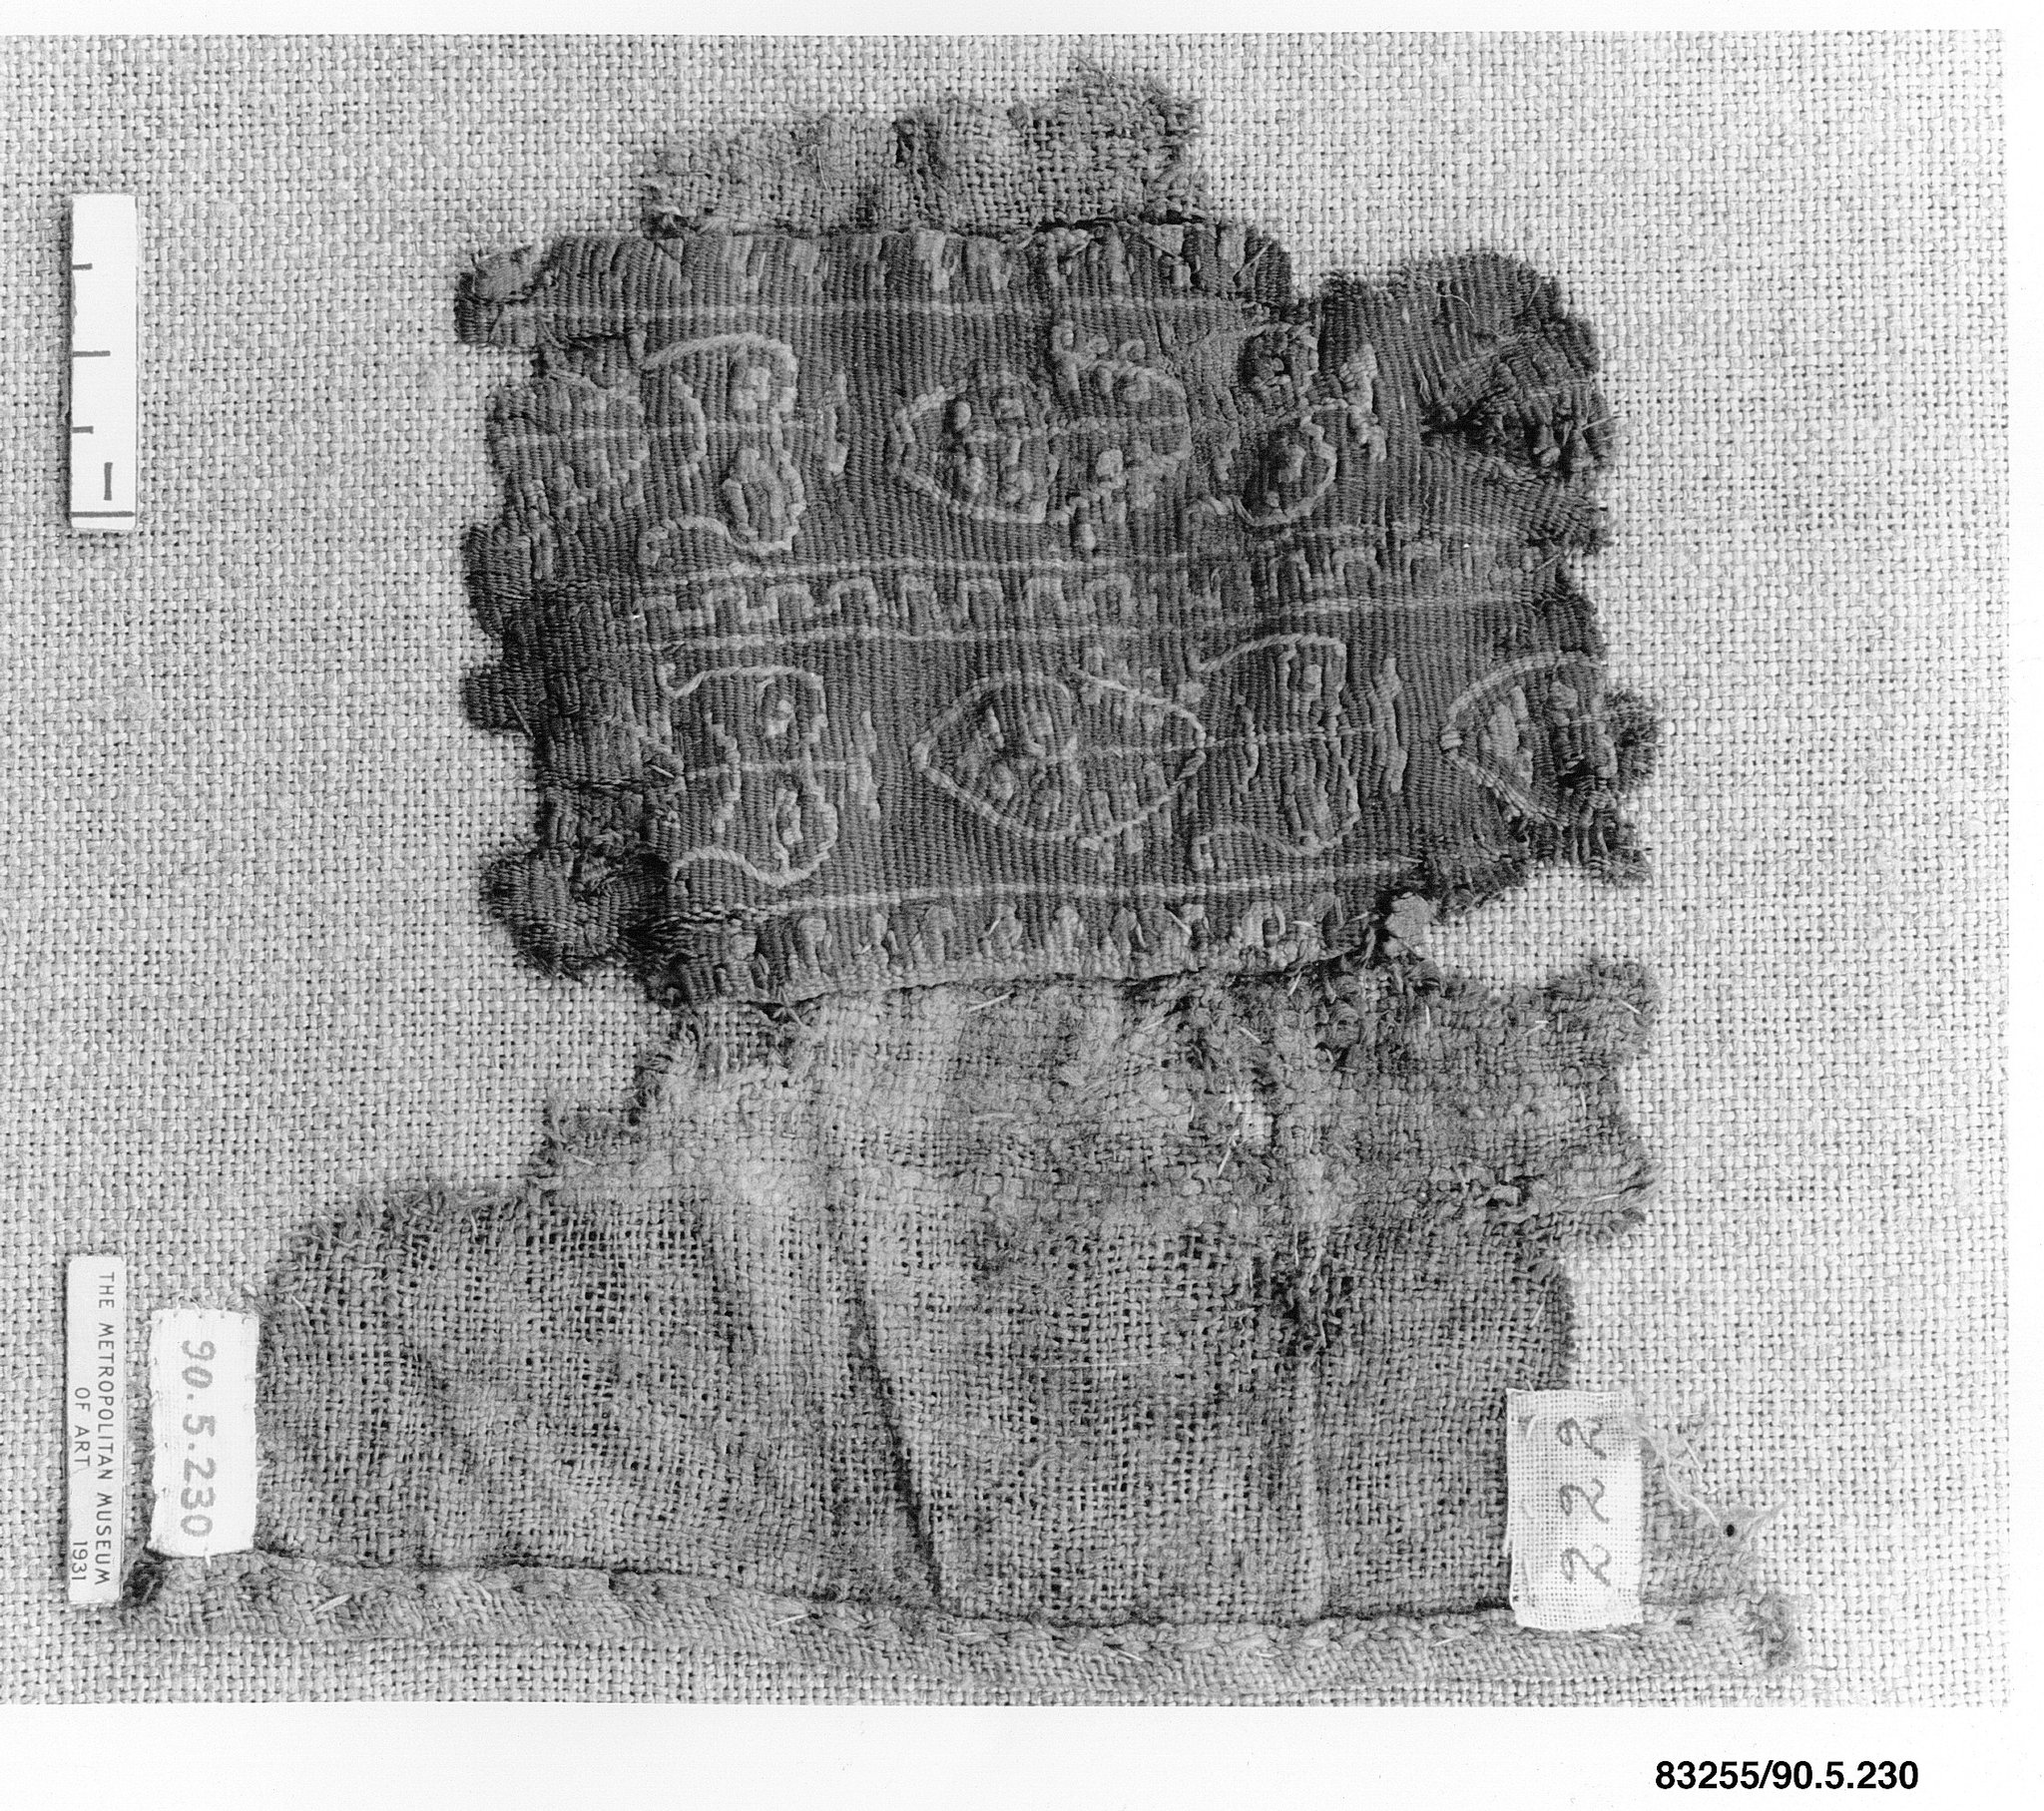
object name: textile fragment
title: Fragment of a Sleeve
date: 401-600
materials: linen, wool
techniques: weave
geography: egypt